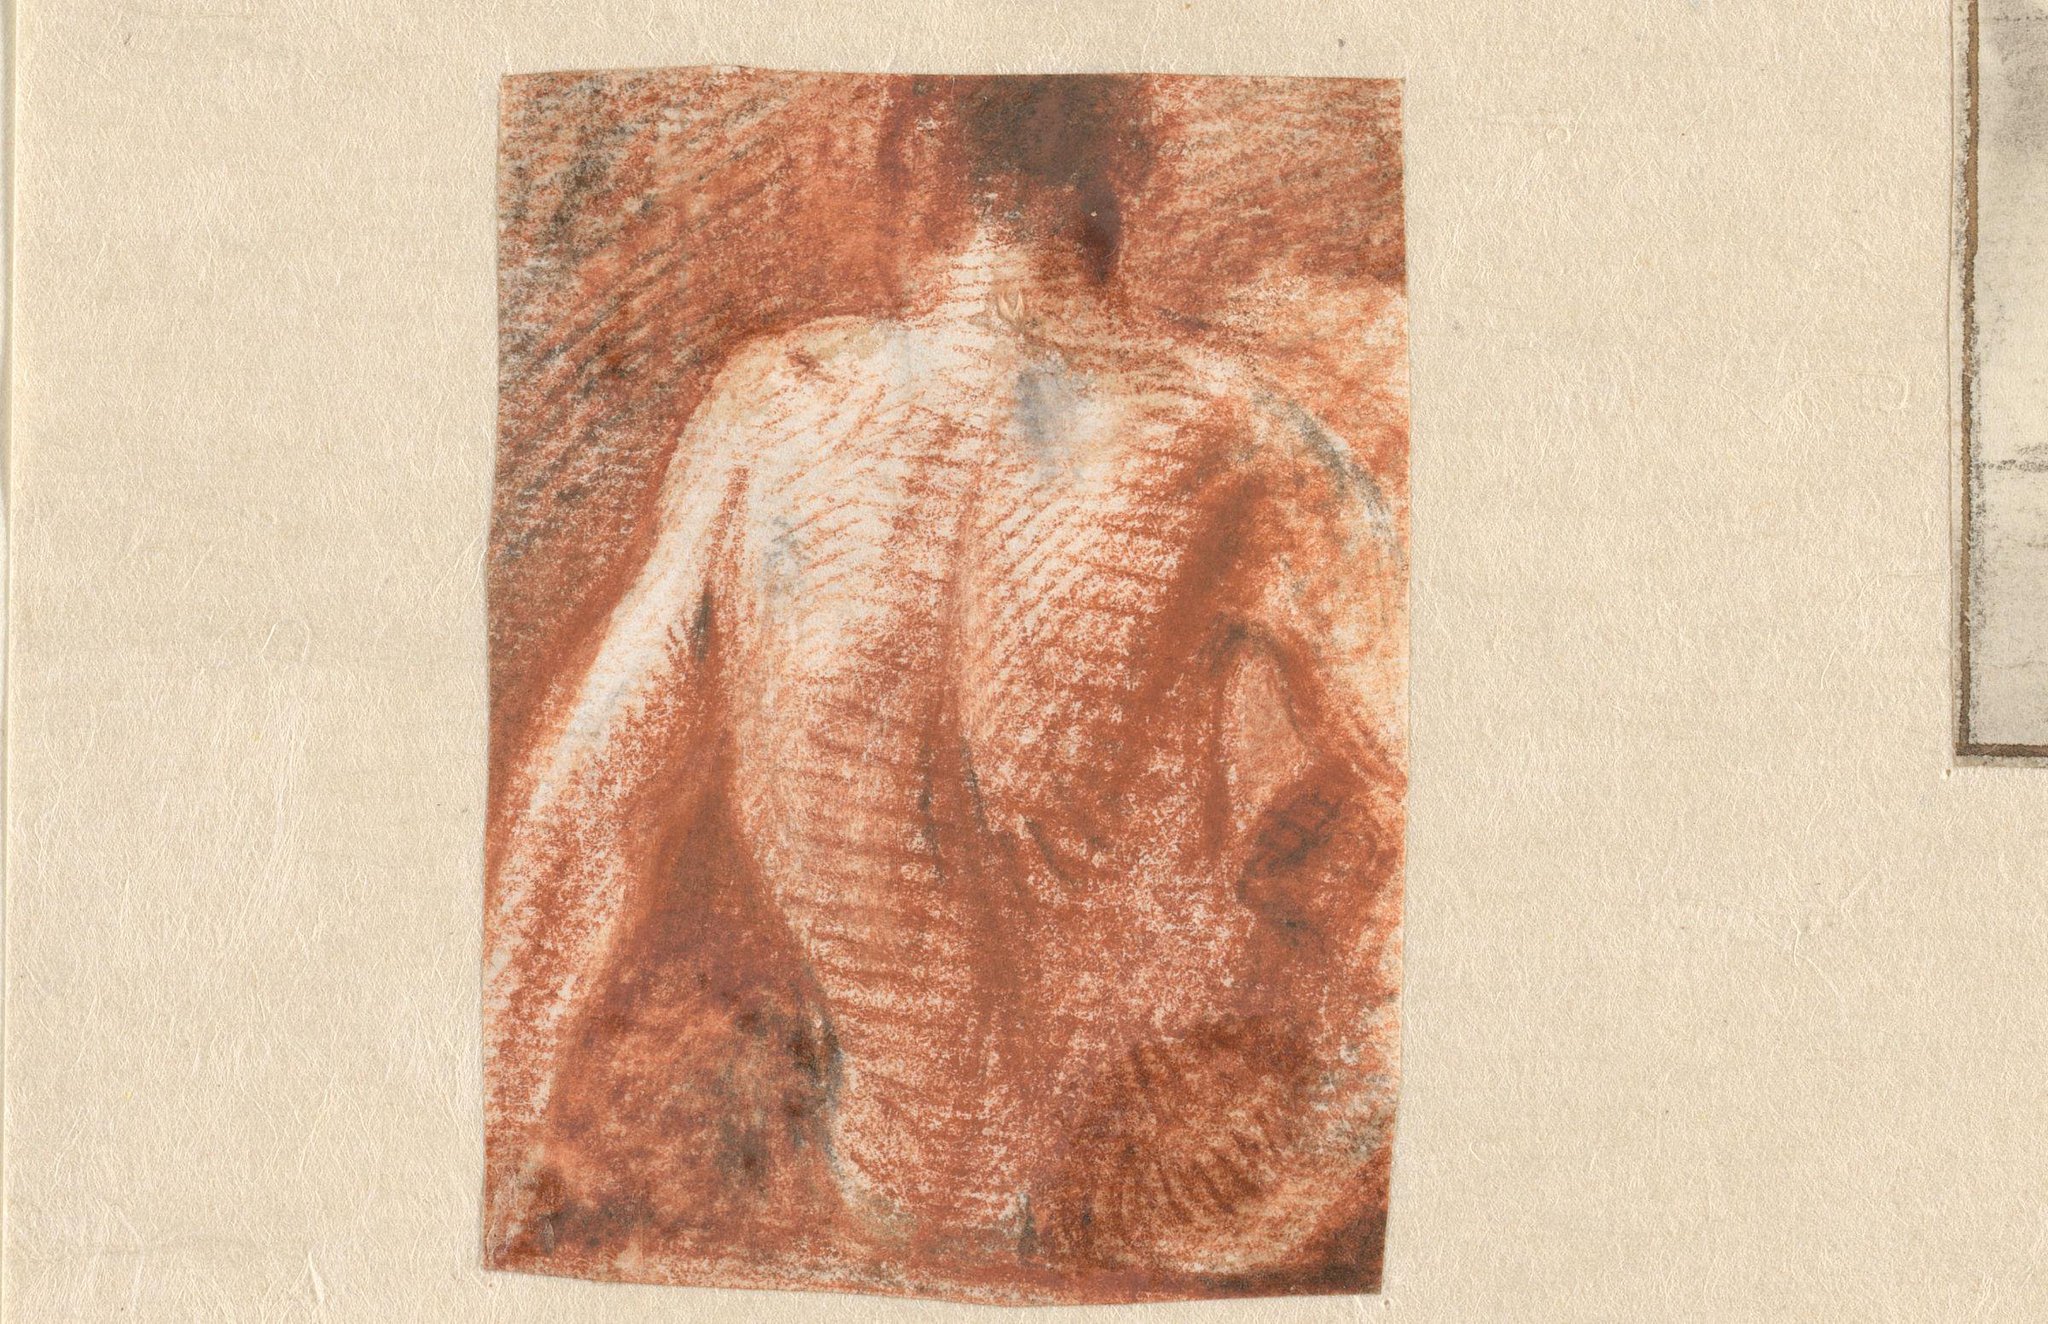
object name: drawing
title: Zittend naakt, op de rug gezien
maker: simon andreas krausz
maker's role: draughtsman, print maker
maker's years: 1760-1825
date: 1770-1825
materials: chalk, paper